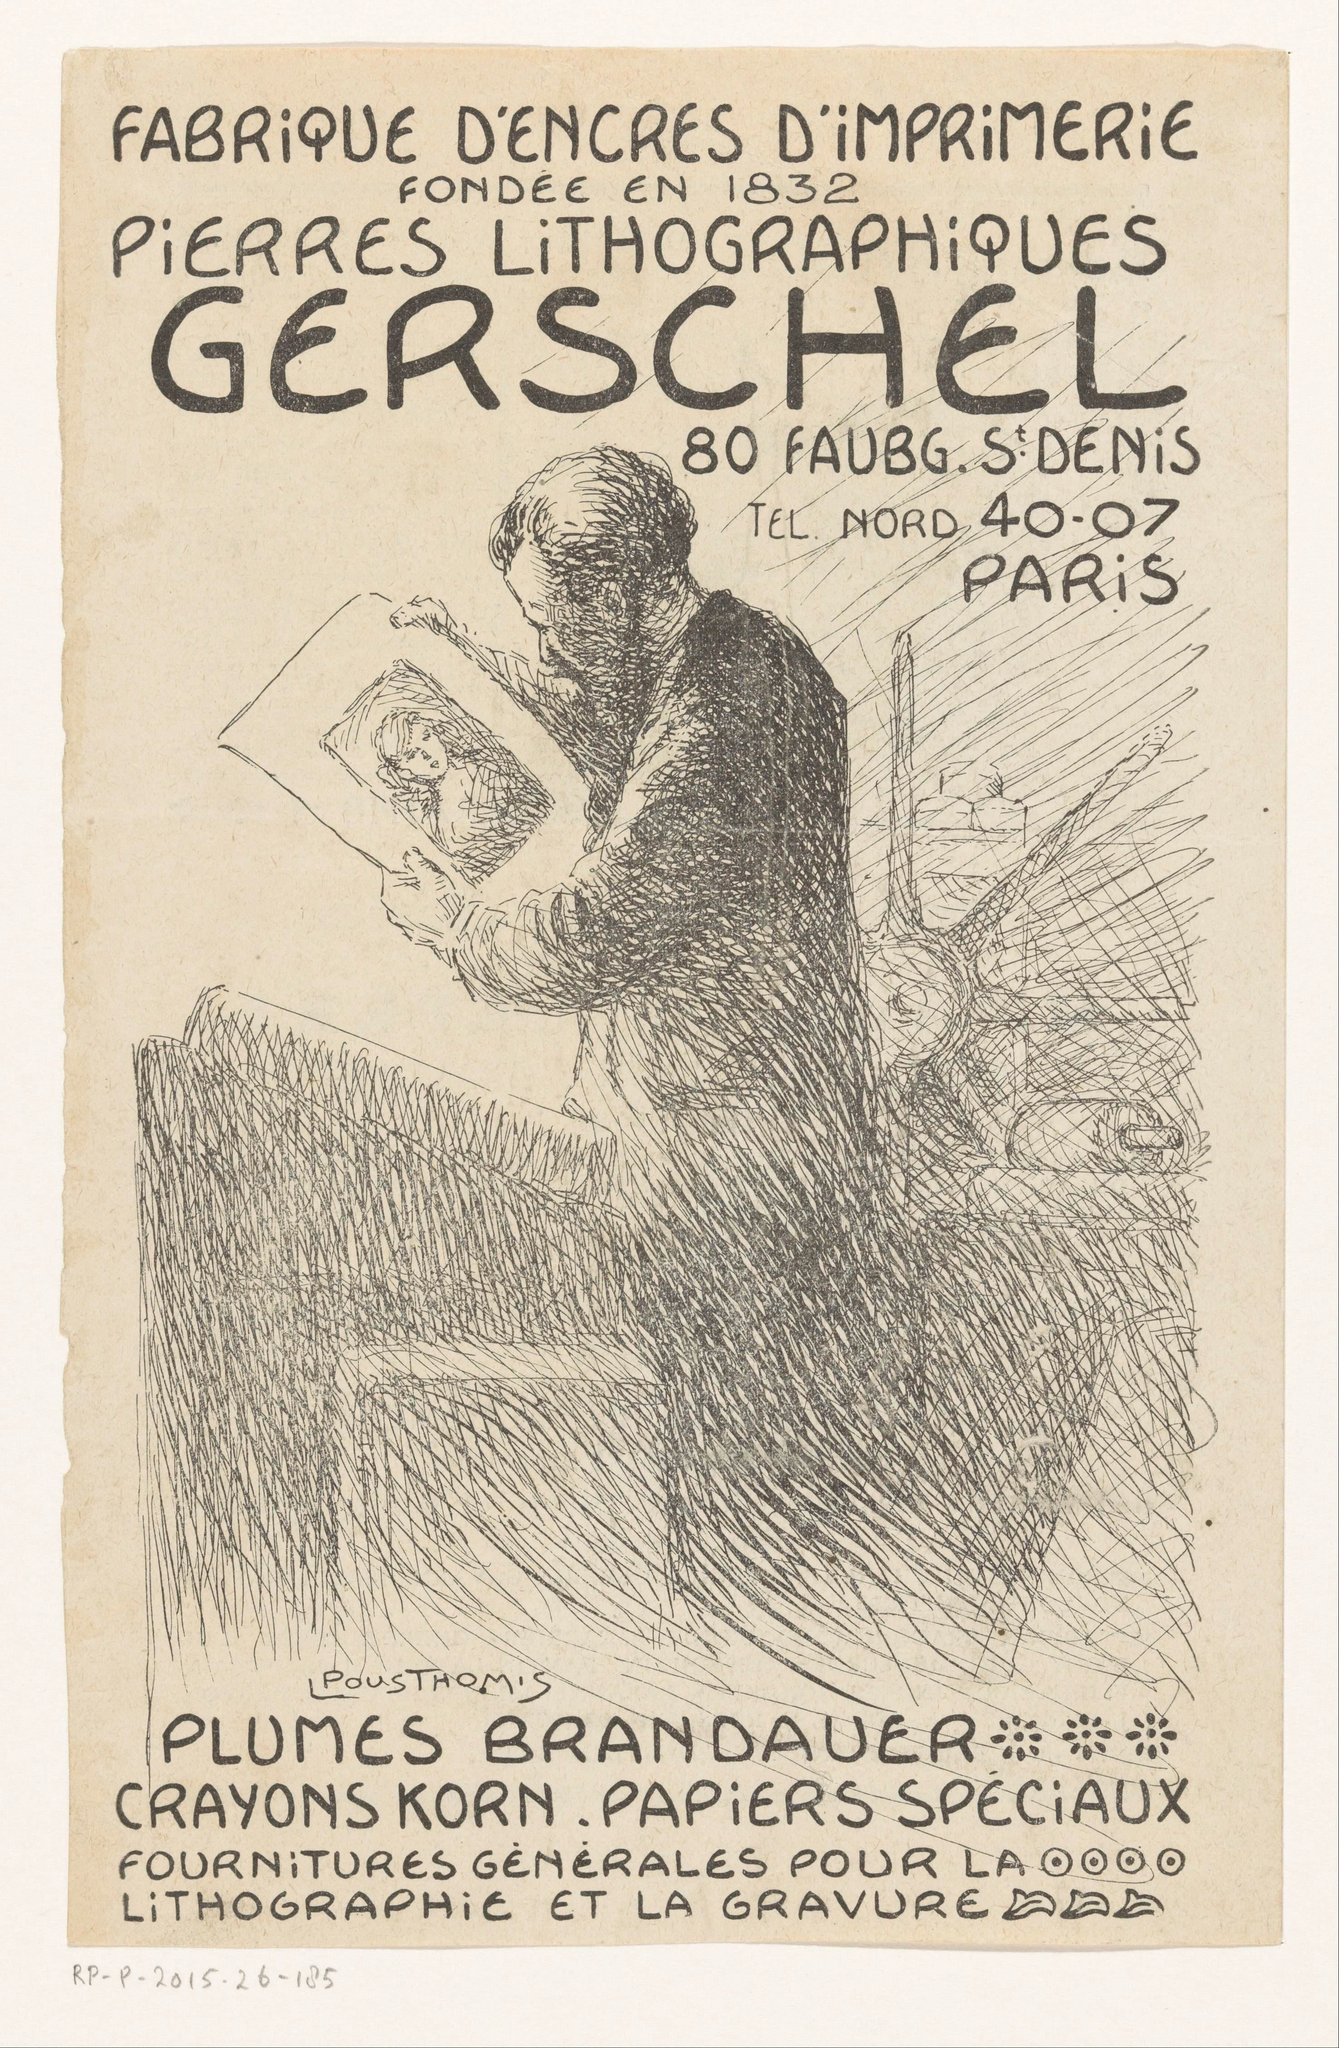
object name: print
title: Advertentie van de firma Gerschel, leverancier van kunstenaarsmaterialen te Parijs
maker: léon auguste pousthomis cesaire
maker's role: print maker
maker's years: 1881-1916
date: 1896-1916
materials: paper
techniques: letterpress printing, lithograph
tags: printing press, workshop, studio of the artist (in general), graphic artist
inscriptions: collector's mark: Lugt 2228, collector's mark: Lugt 4779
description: Een man inspecteert een prent, een lithopers op de achtergrond. Een advertentie van uitgever en prenthandel Edmond Sagot op verso.